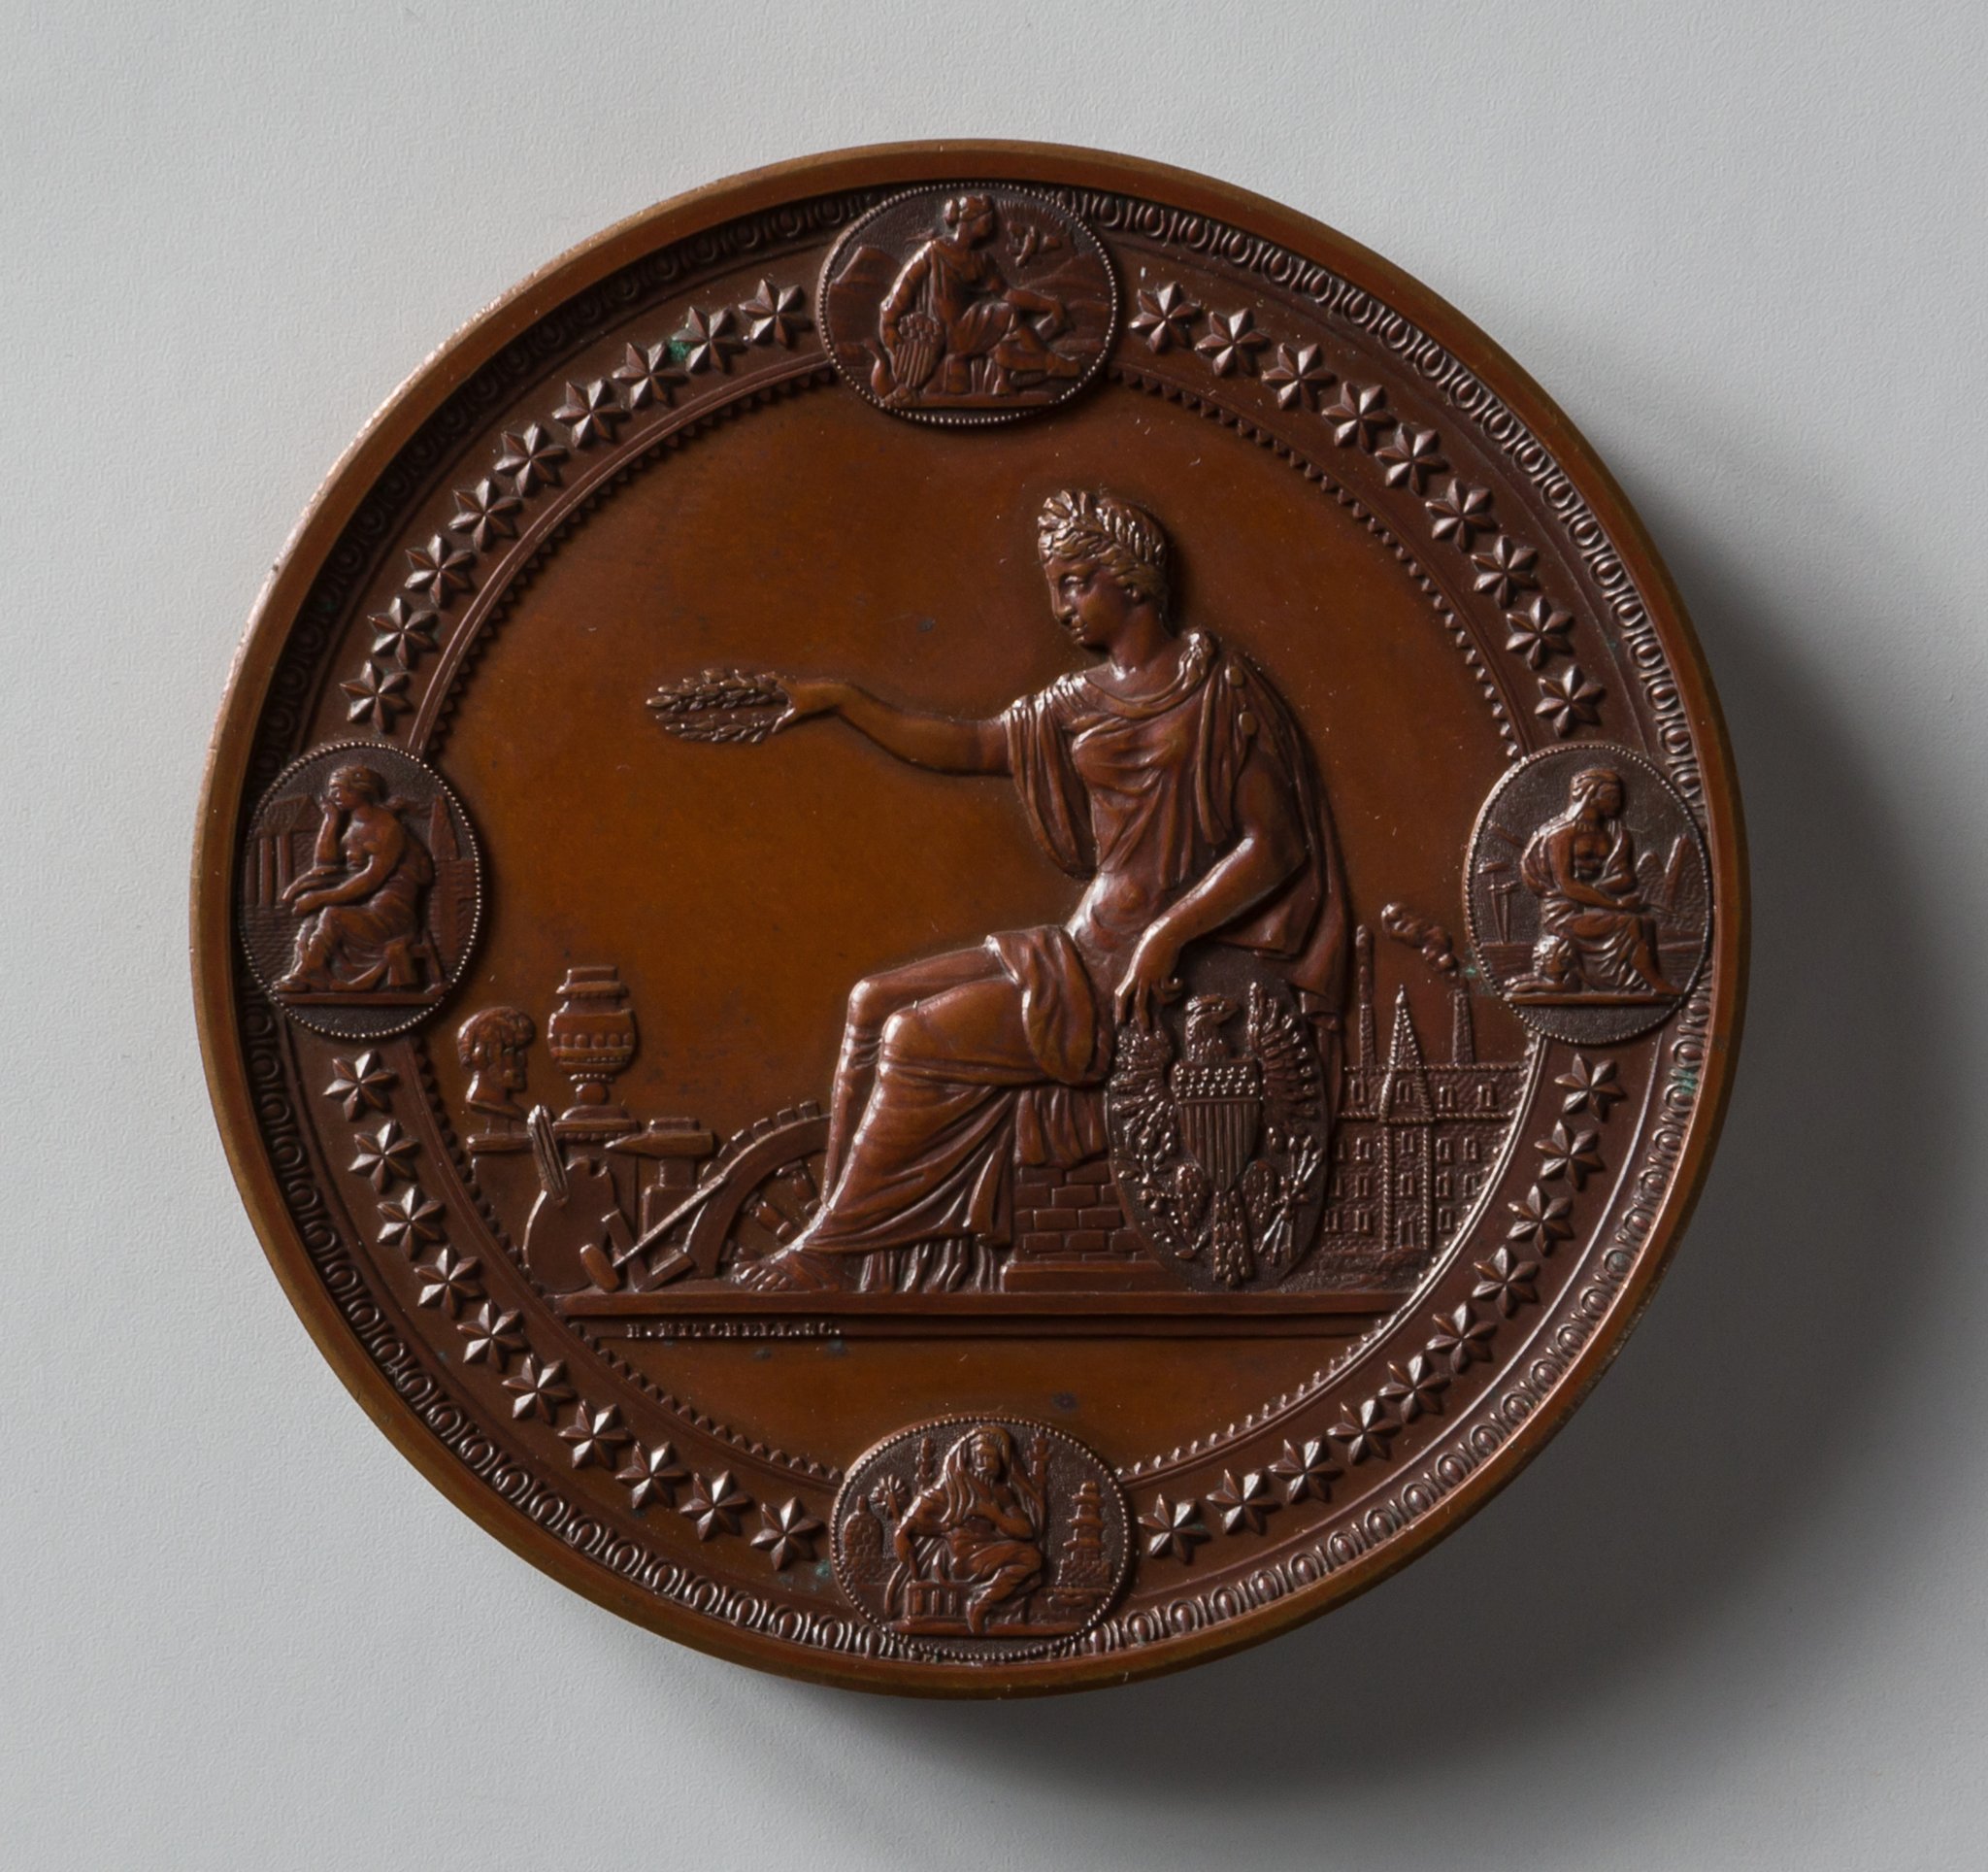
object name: medal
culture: american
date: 1789-1800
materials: bronze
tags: human figures